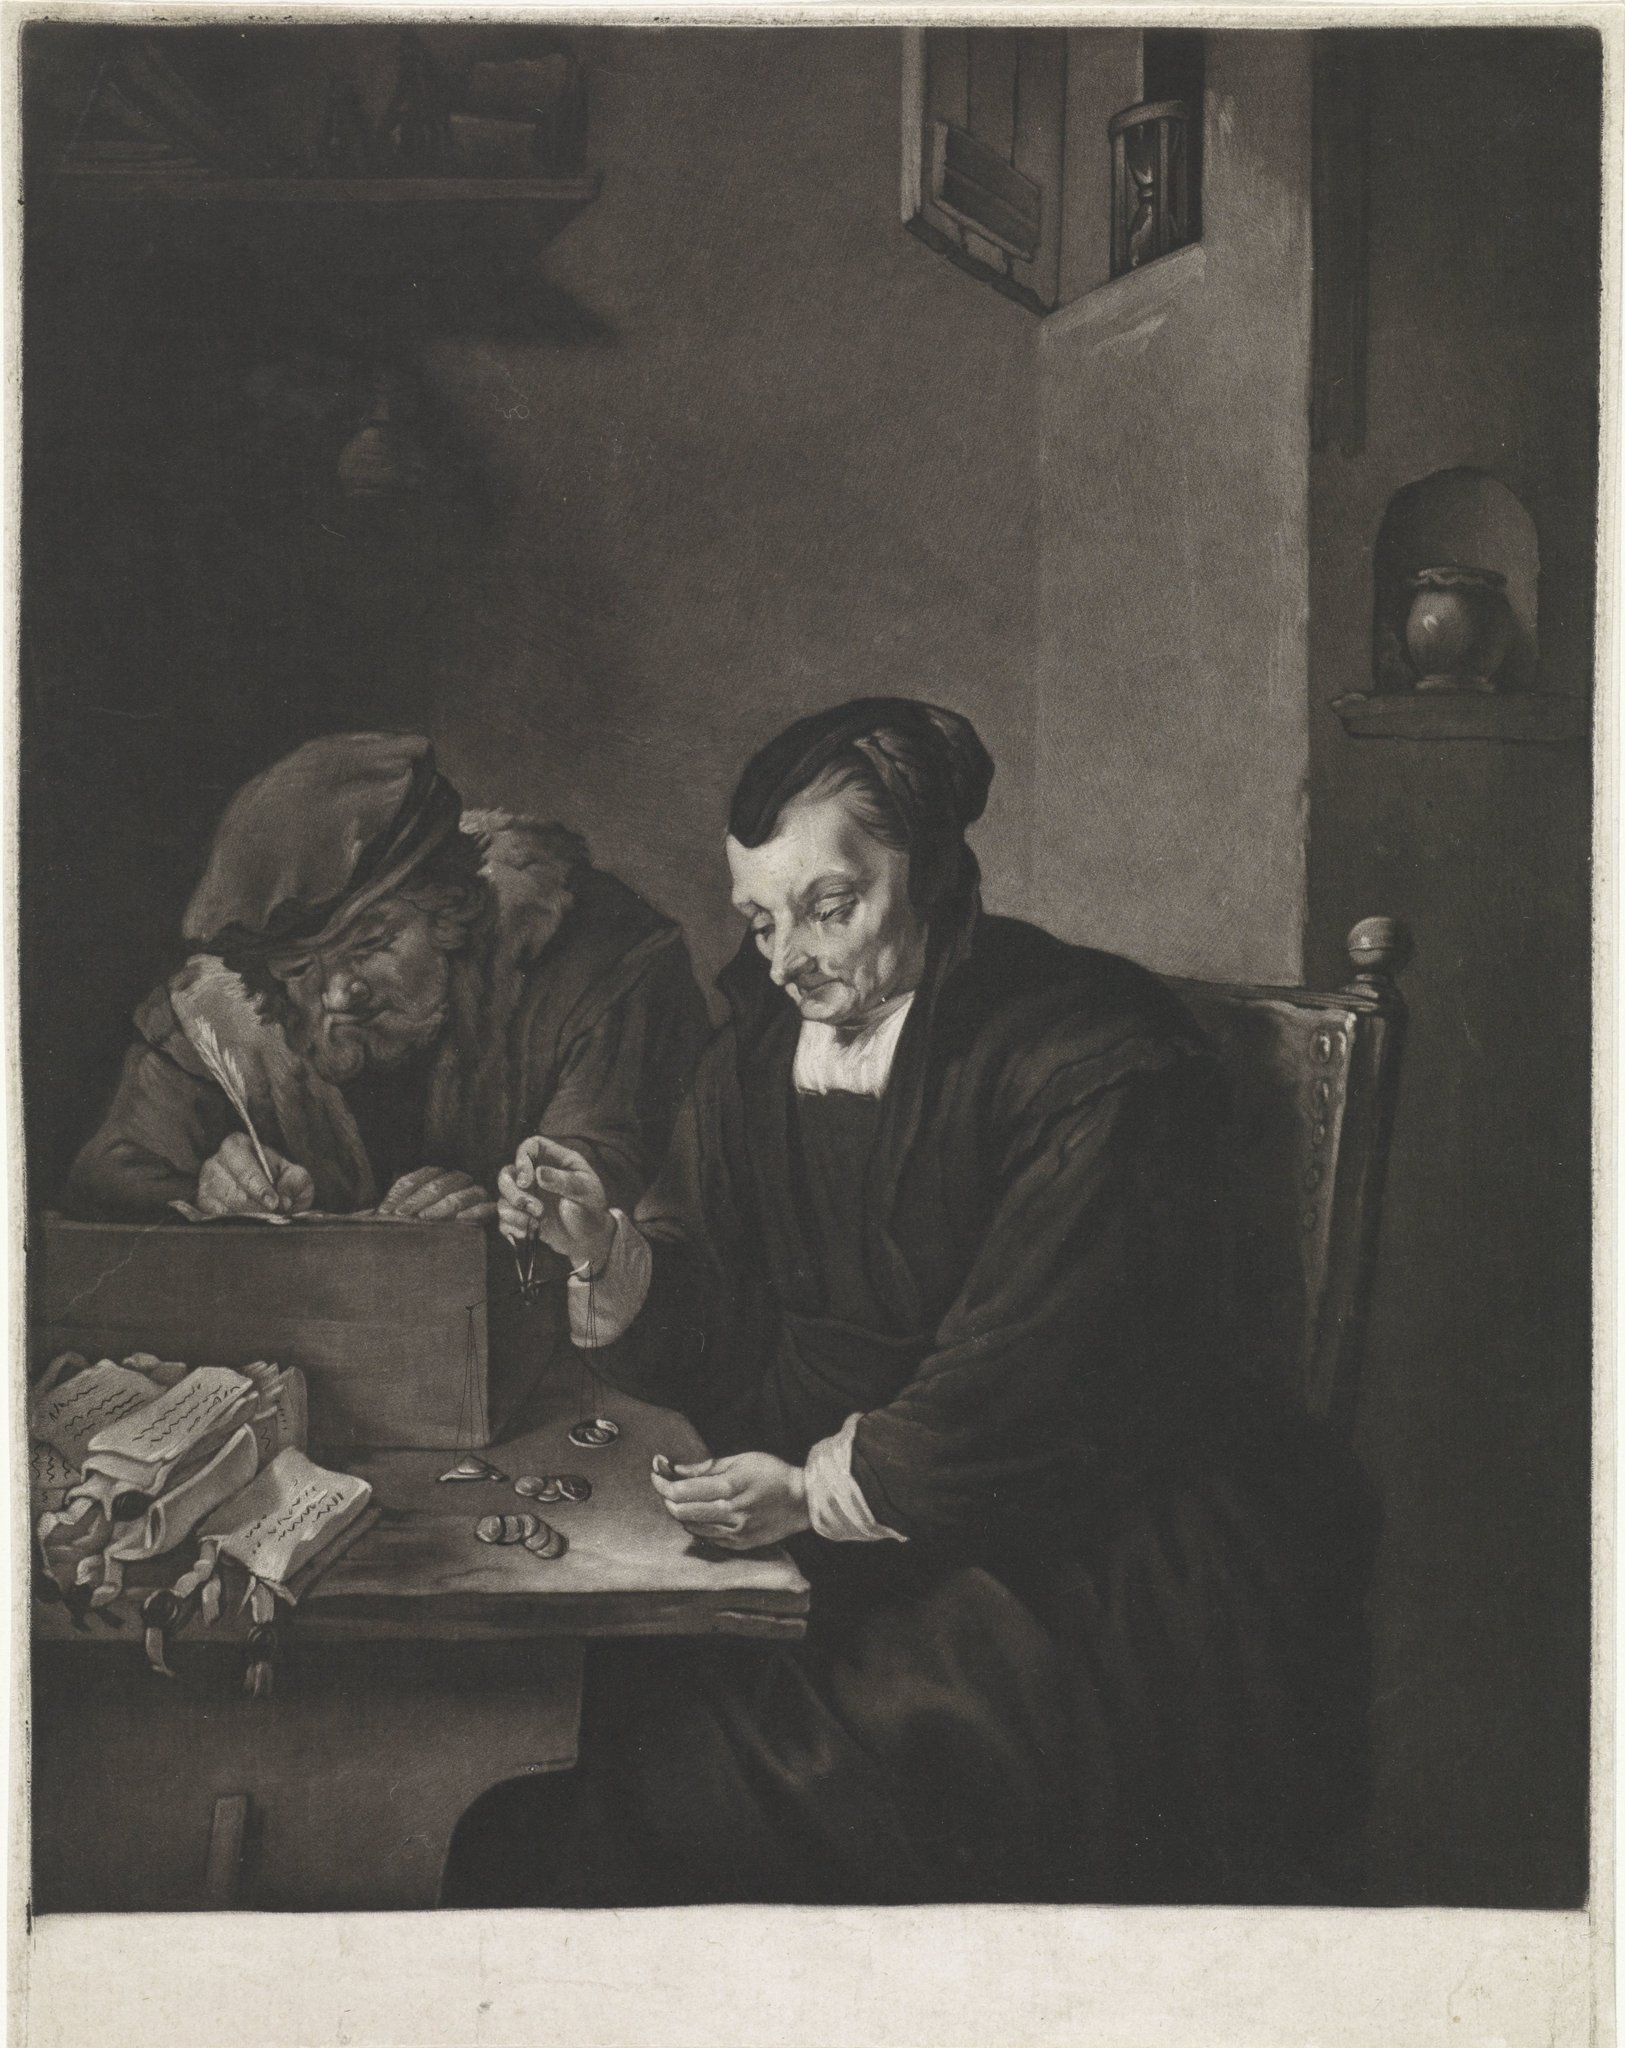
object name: print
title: Goudweegster (variant zonder duivels)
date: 1659-1790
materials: paper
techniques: mezzotint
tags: handwriting, writing as activity, personifications of death; 'morte' (ripa), weighing gold or money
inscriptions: collector's mark: Lugt 2228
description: De prent is een kopie naar een prent van Jan van der Bruggen met een gelijknamige titel, waarvan een variant met duivels bestaat.